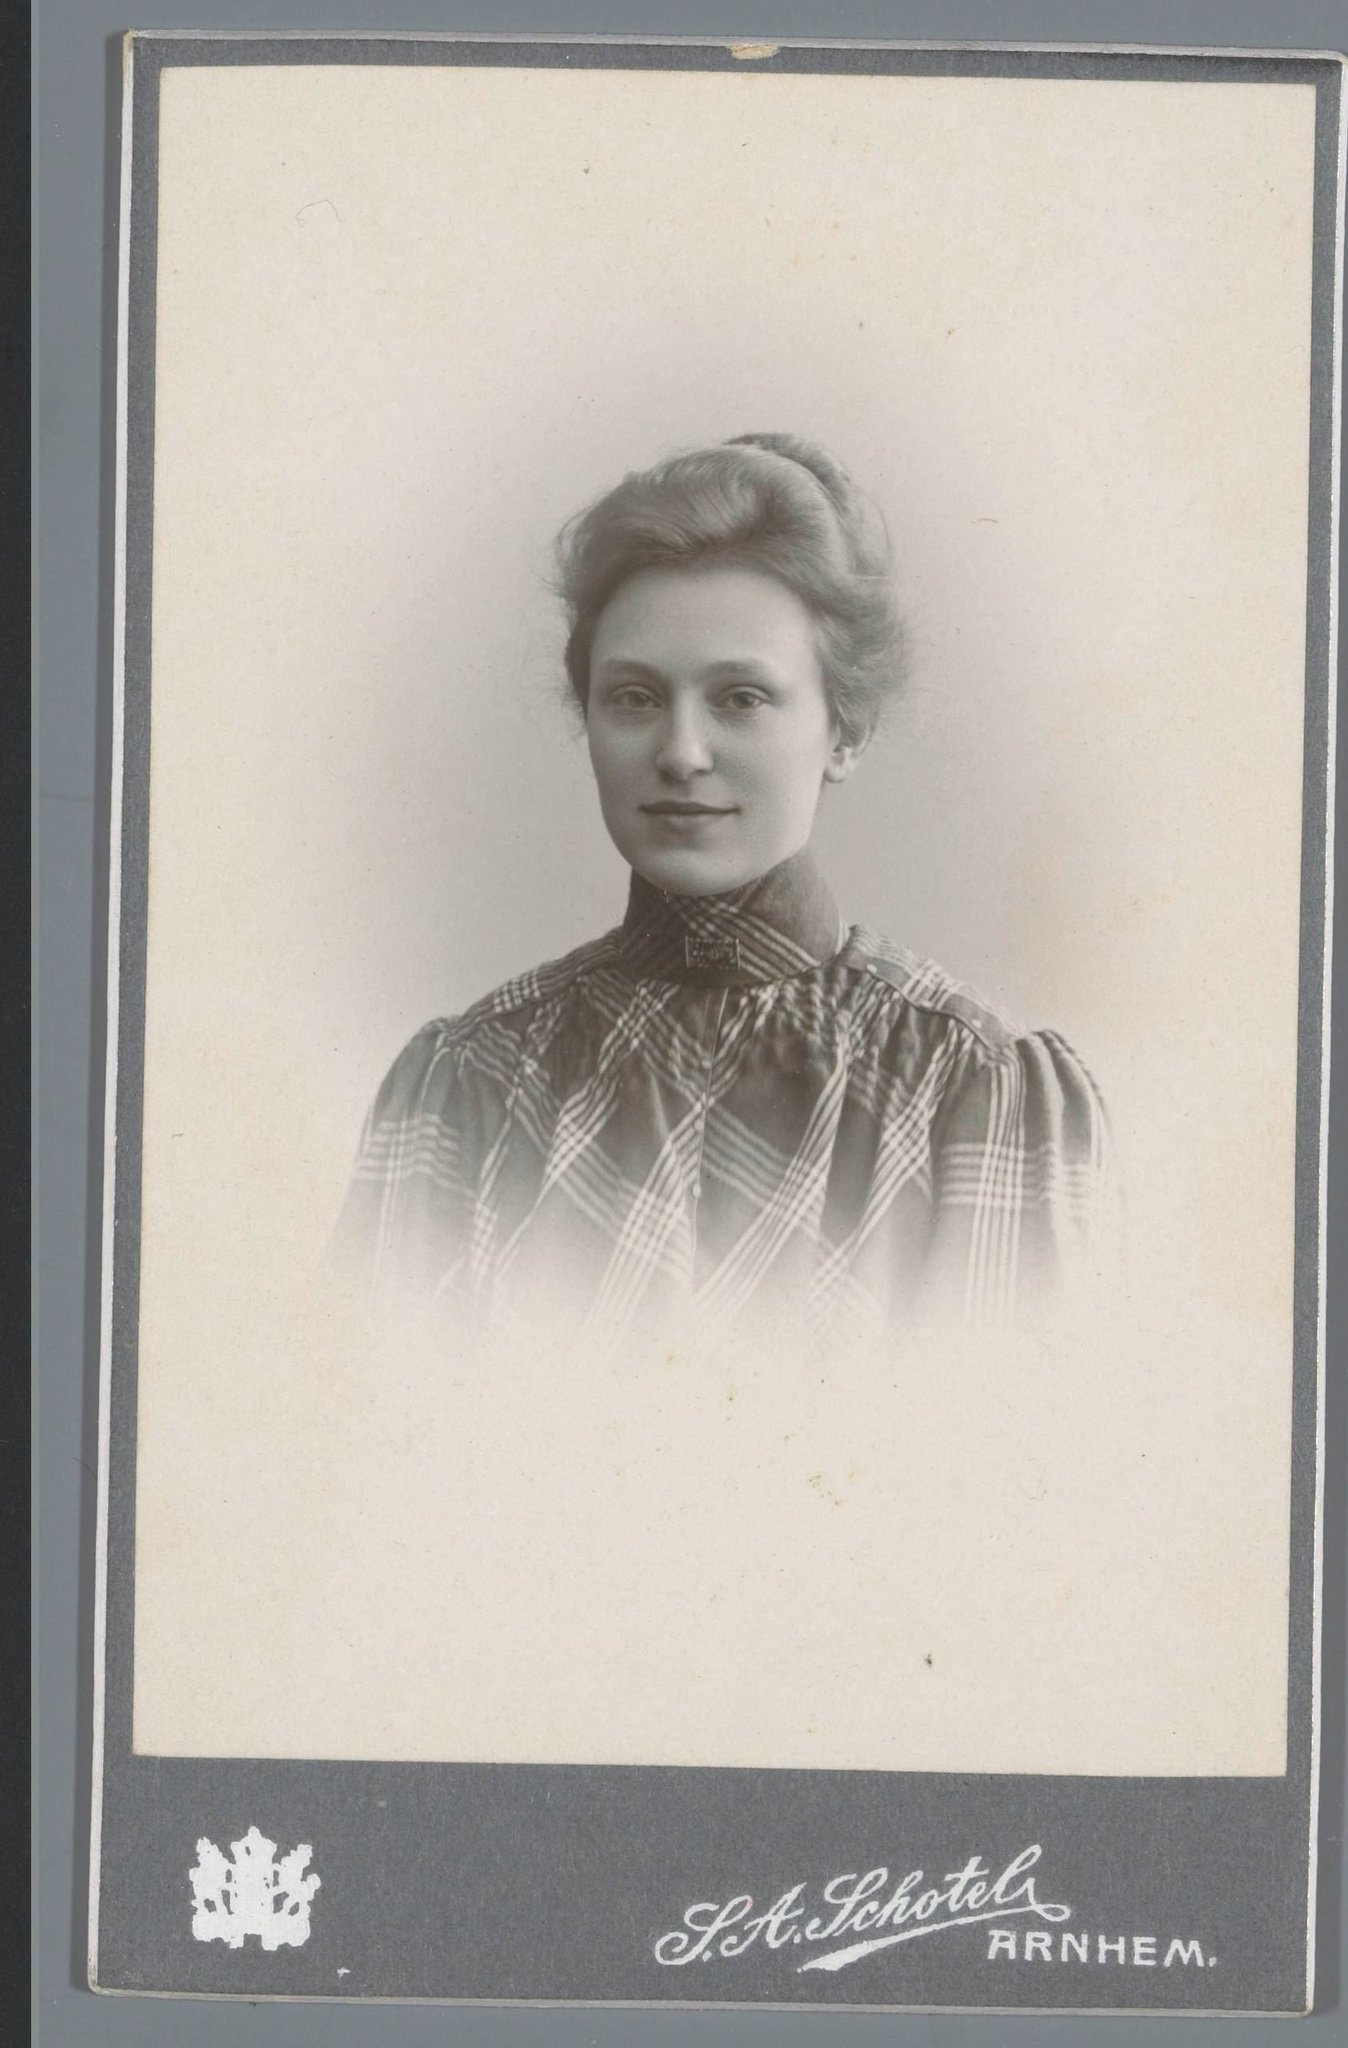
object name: photograph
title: Portret van Wies de Raaf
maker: stephanus adrianus schotel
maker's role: fotograaf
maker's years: 1871-1957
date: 1905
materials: paper, cardboard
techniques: gelatin silver print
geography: arnhem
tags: adult woman, historical persons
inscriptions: address: ‘Velperbuitensingel 10/ ARNHEM’, inscription: ‘PLATEN BLIJVEN/ VOOR NABESTELLING BEWAARD./ Prager & Lojda, Berlin./ 25604’